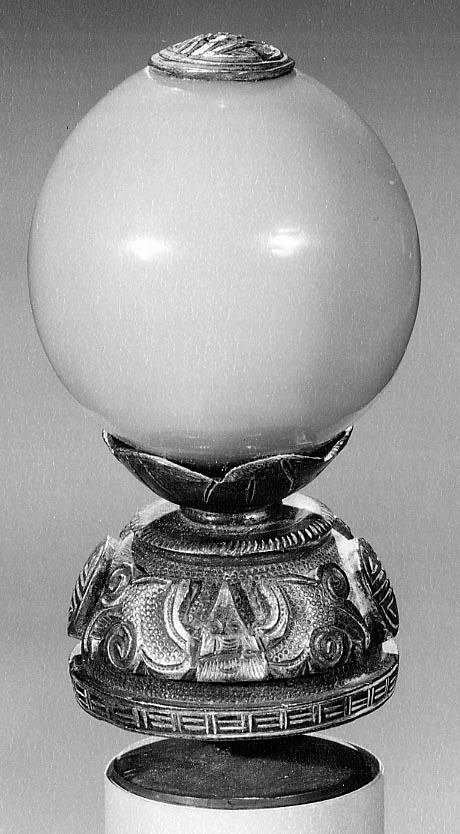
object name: hat finial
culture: chinese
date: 1901-1933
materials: glass